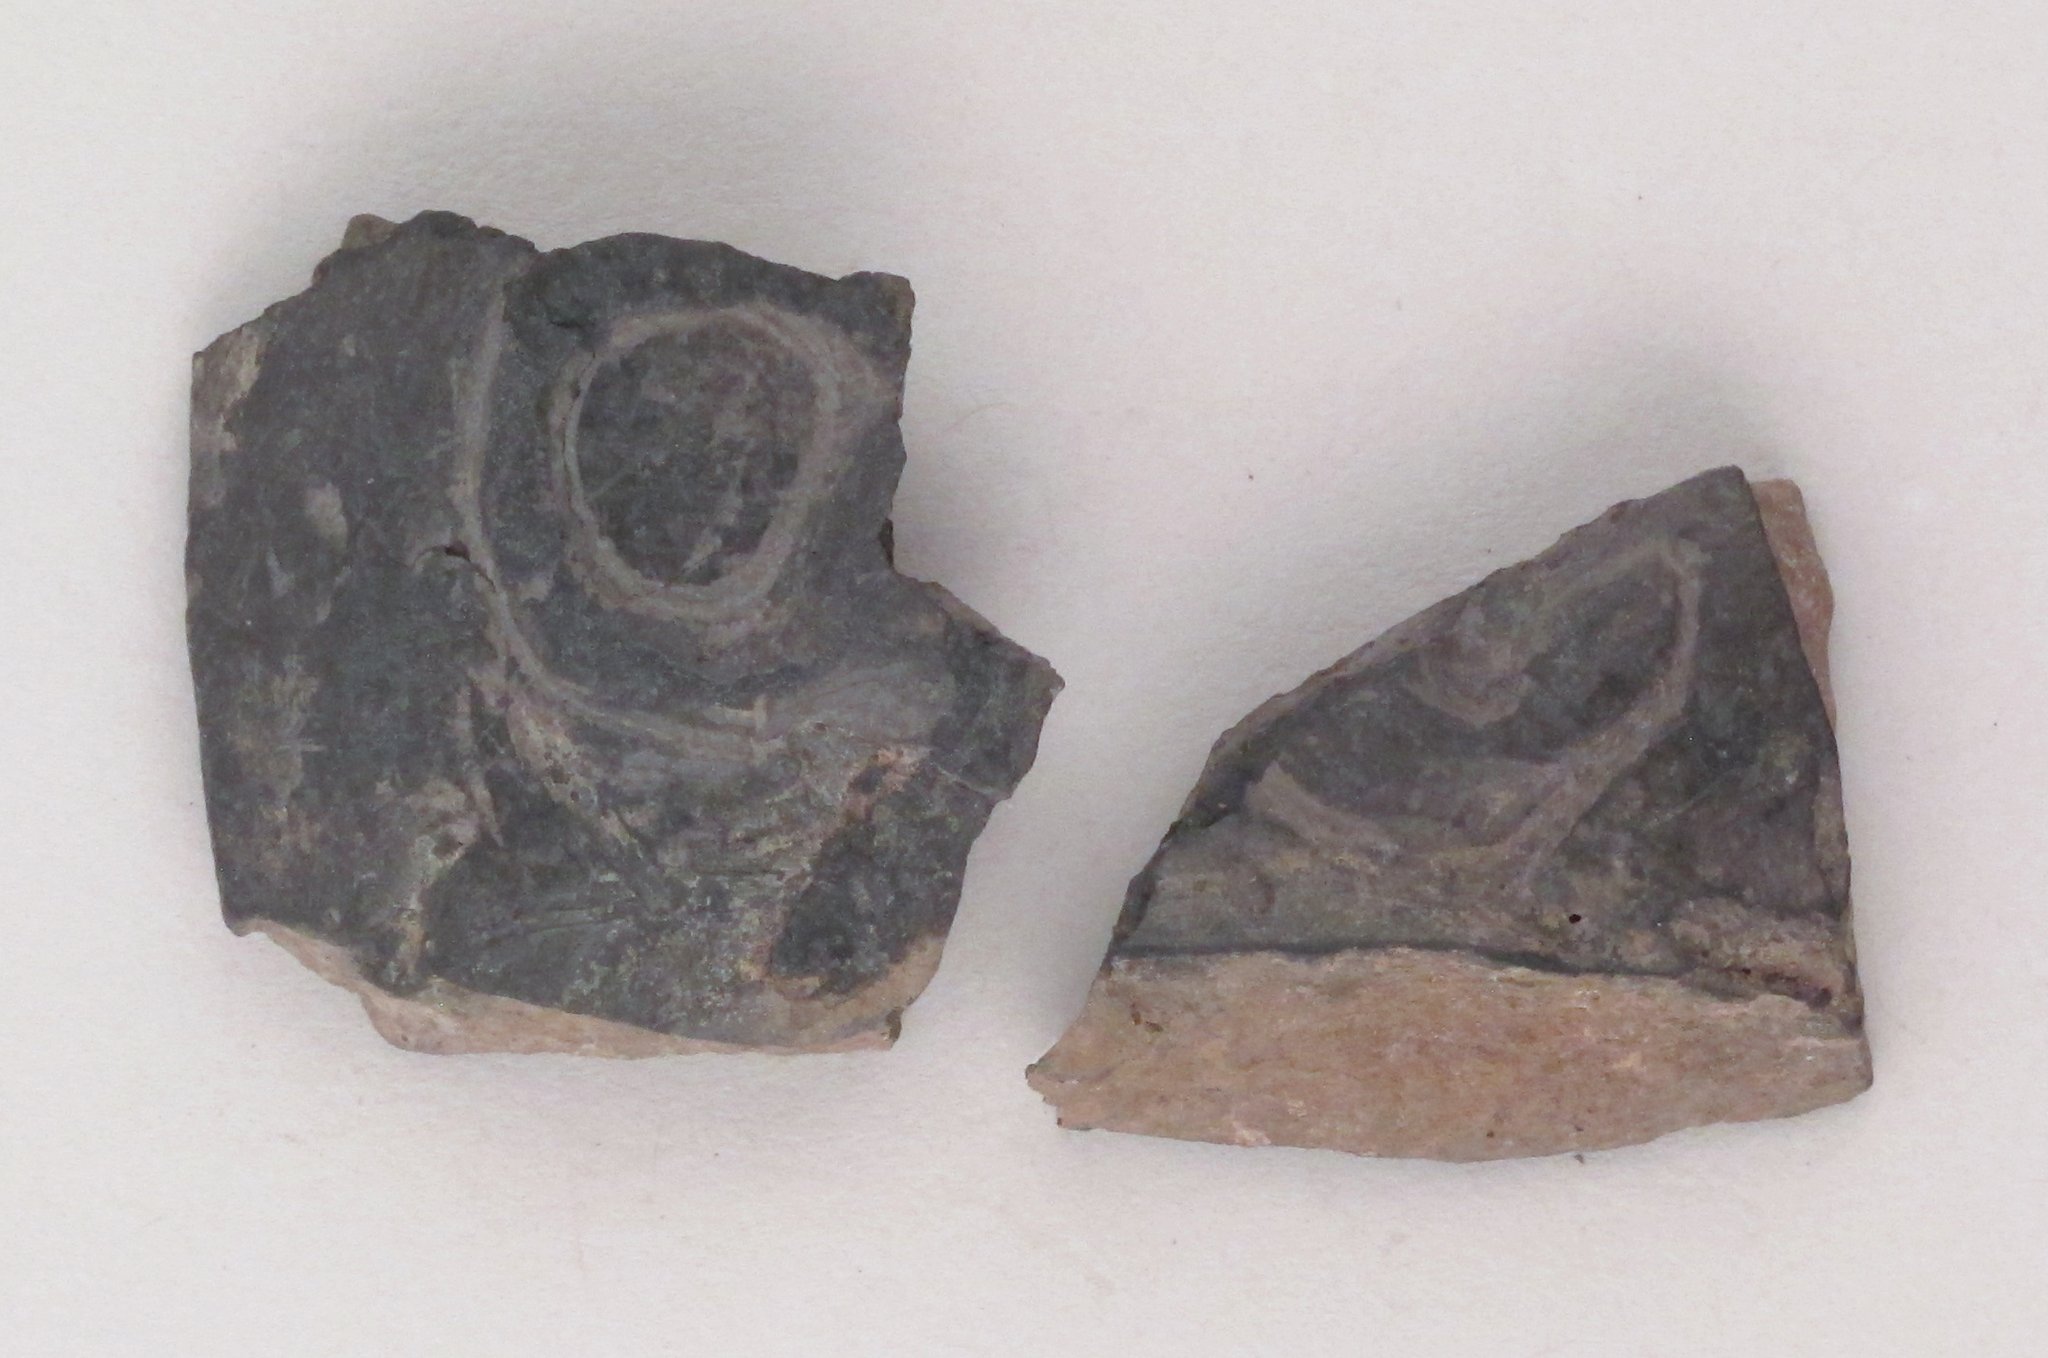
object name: vase fragment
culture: etruscan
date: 580-550 BCE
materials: terracotta